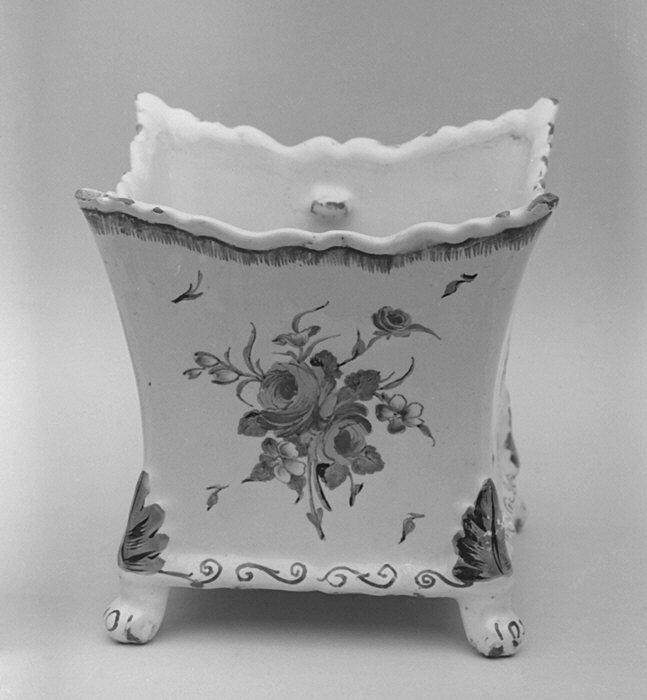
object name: jardinière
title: Jardinières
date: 1775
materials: earthenware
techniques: glazing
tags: flowers